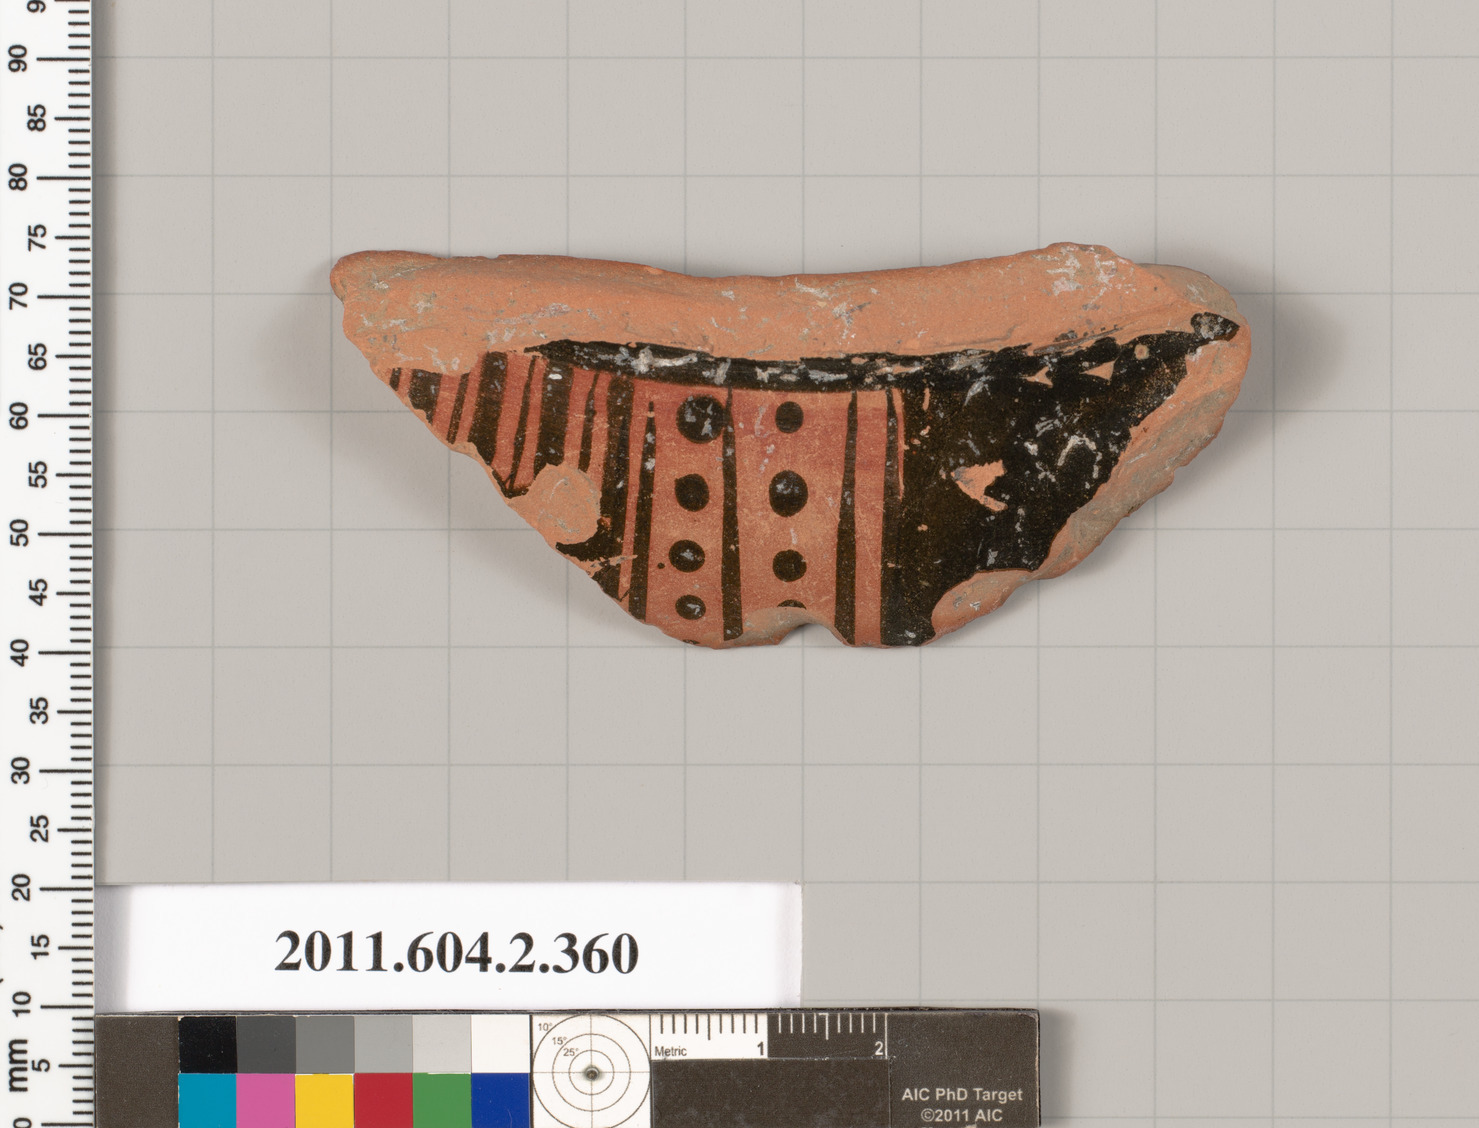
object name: column krater fragment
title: Terracotta fragment of a column-krater (bowl for mixing wine and water)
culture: greek, attic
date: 450-430 BCE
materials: terracotta